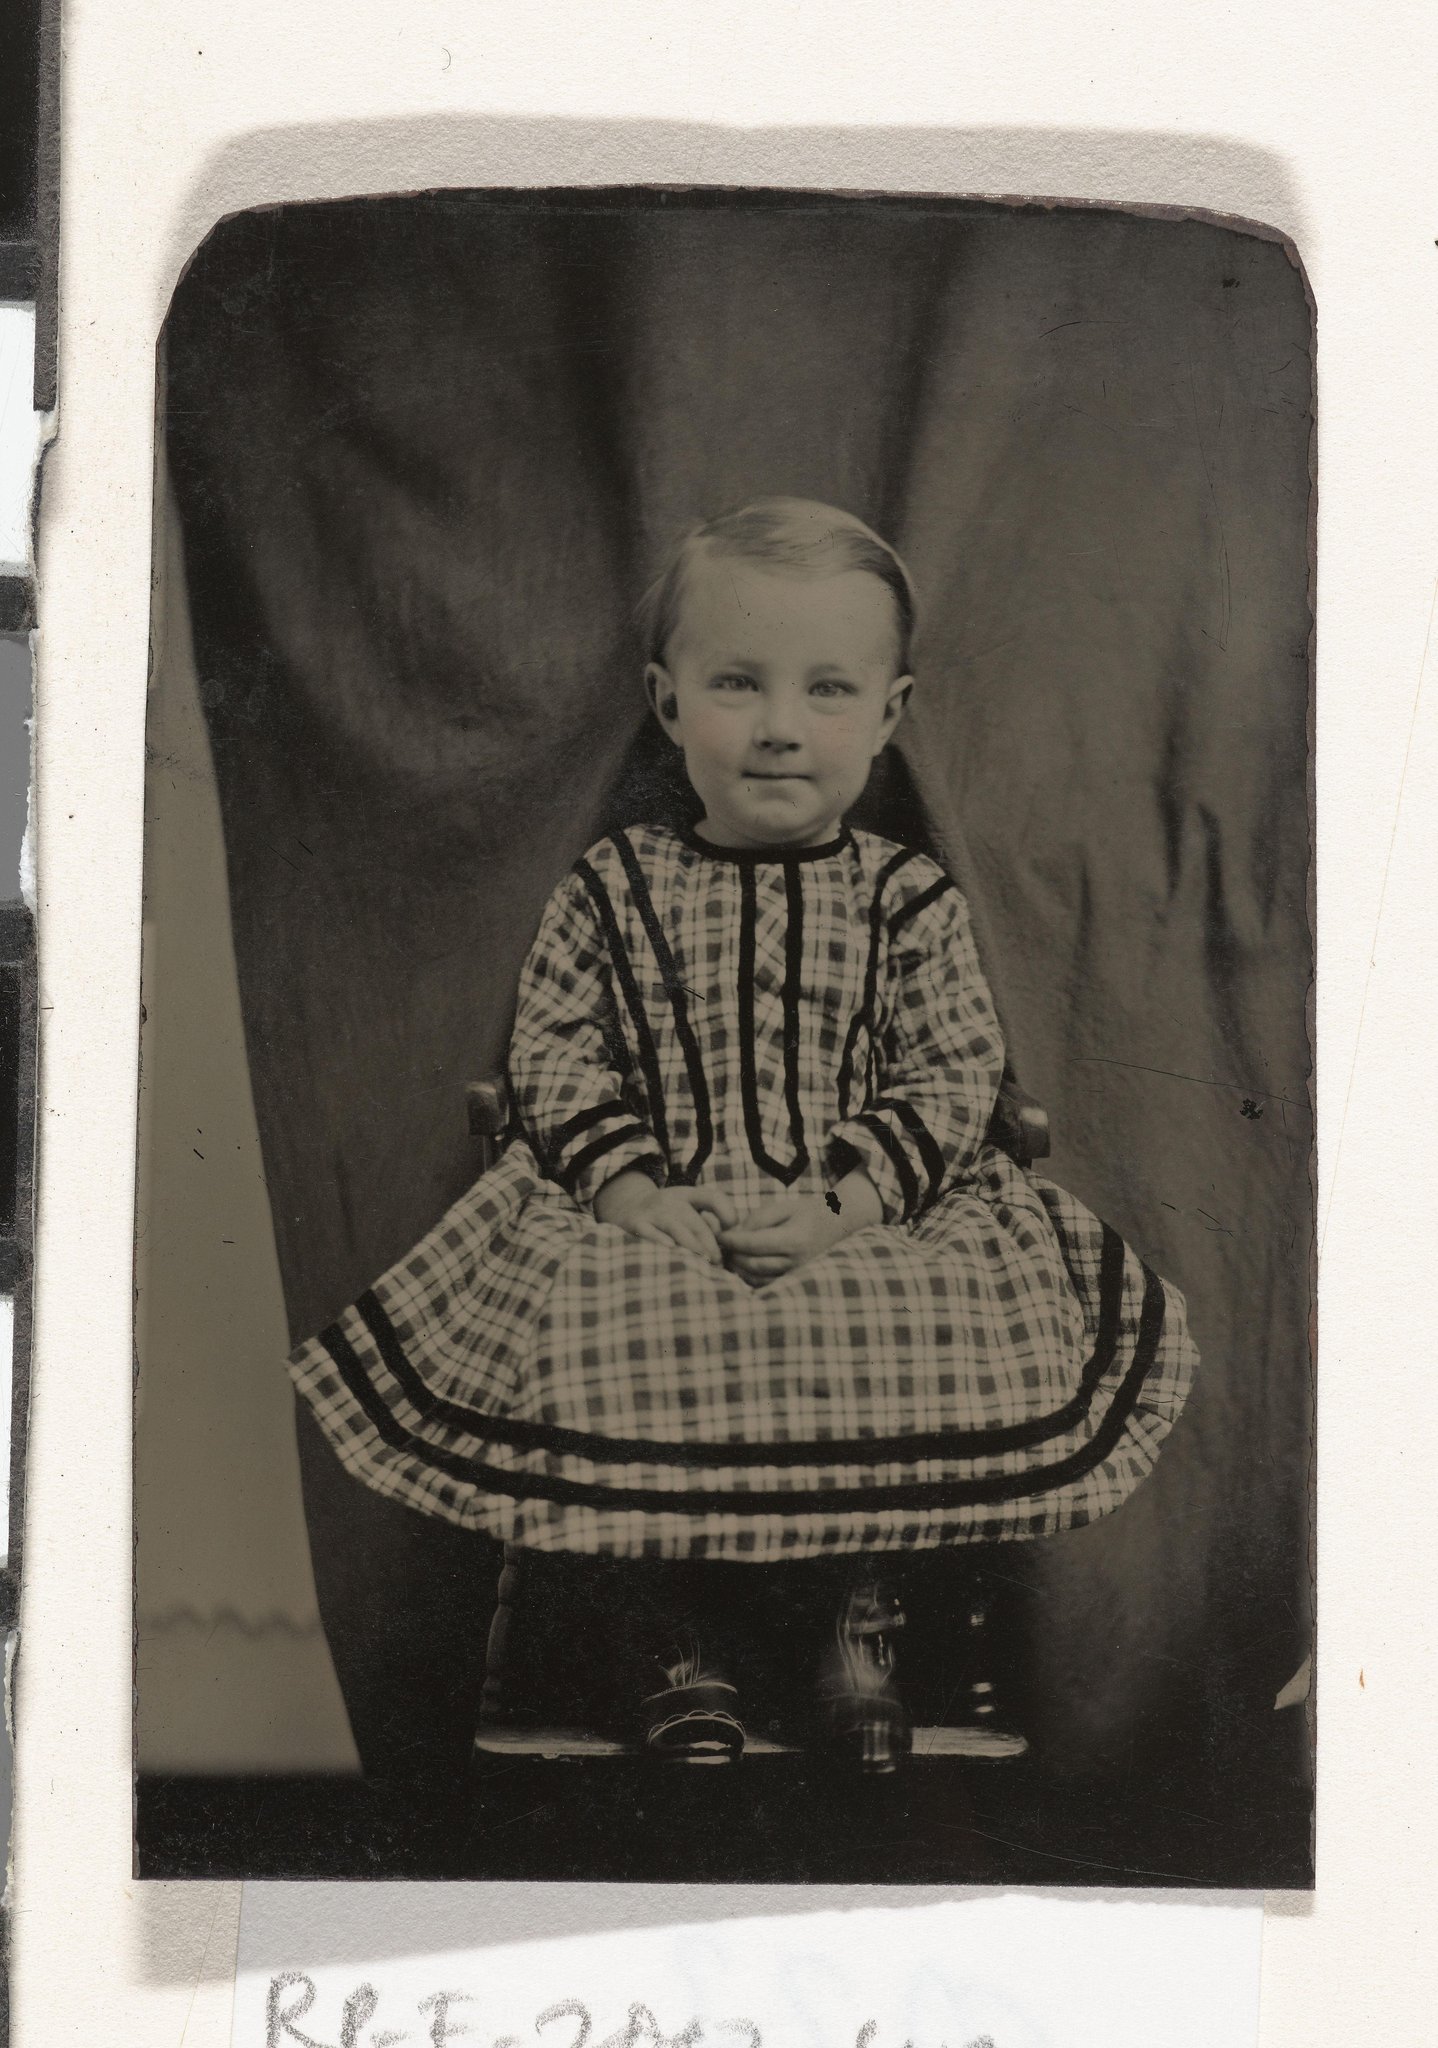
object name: photograph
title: Portret van een kind, zittend op een stoel in een studiodecor (met achter het doek ongetwijfeld de moeder die haar kind (quasi-)onzichtbaar vassthoudt ('hidden mother')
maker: Anonymous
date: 1870-1900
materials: metal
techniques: ferrotyping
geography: united states